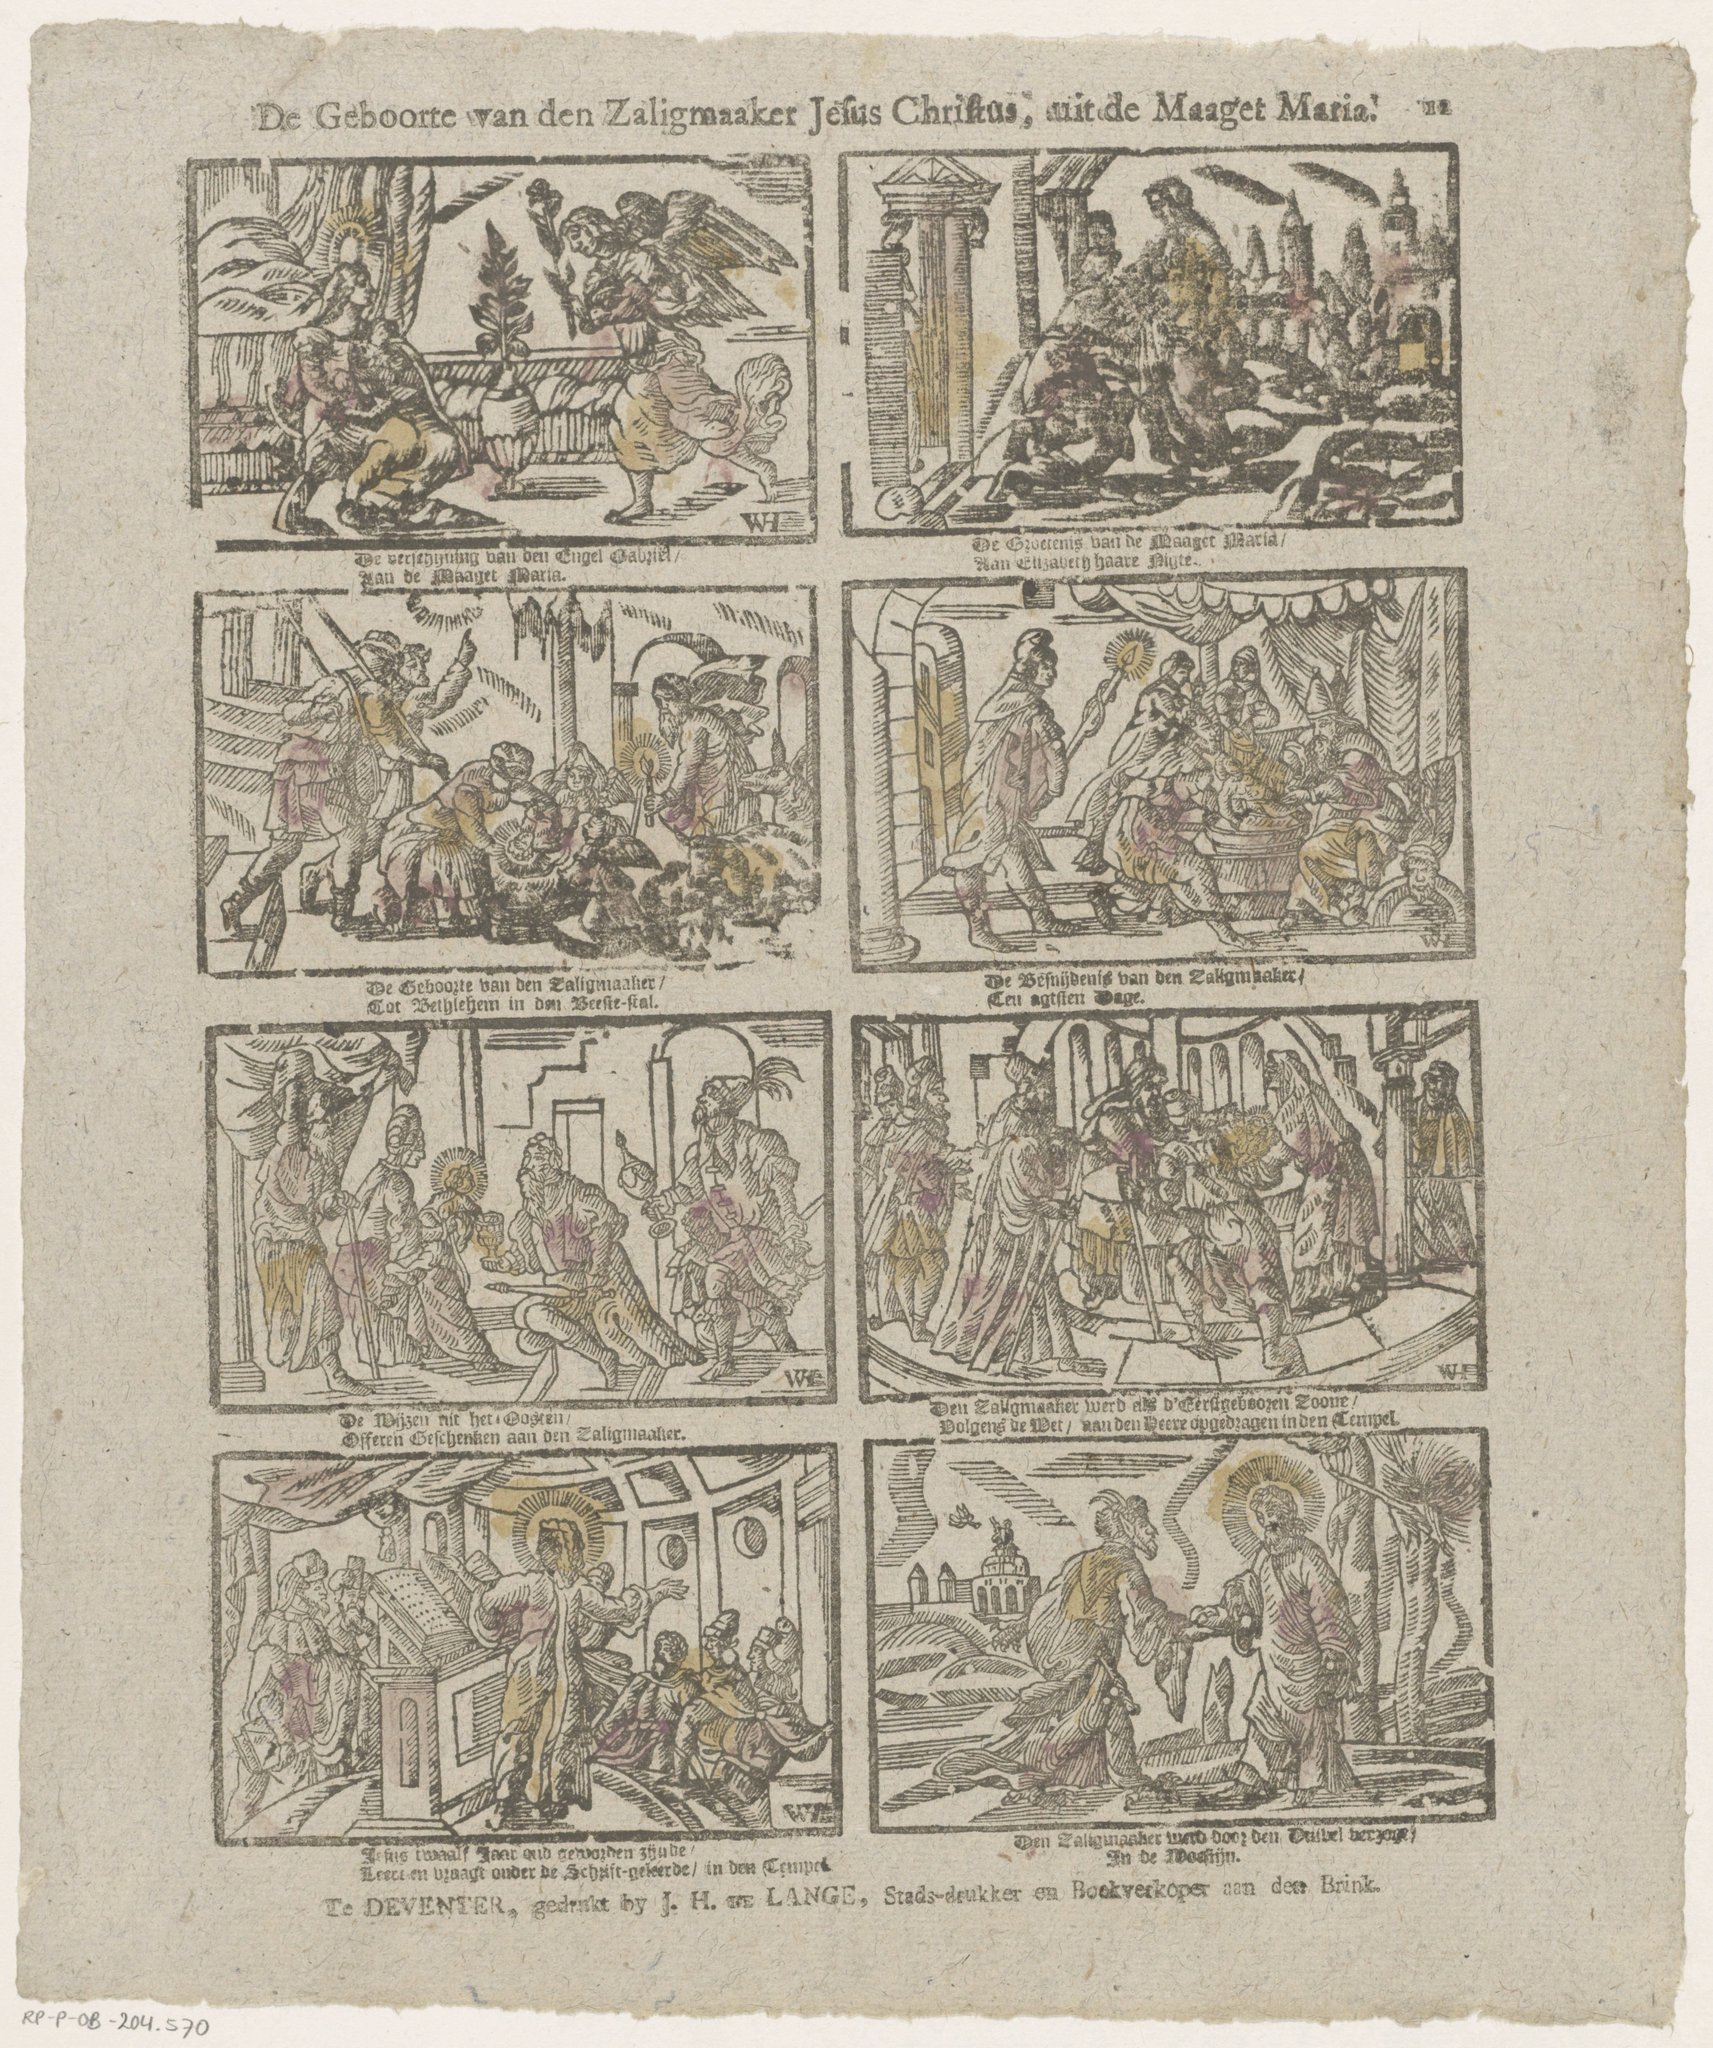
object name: popular print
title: De geboorte van den zaligmaaker Jesus Christus, uit de maaget Maria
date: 1787-1822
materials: paper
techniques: colour, letterpress printing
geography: deventer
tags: adoration of the christ-child by the shepherds; mary and joseph present, new testament, the annunciation: mary sitting, series of scenes from the life of christ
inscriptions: collector's mark: Lugt 2760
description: Blad met 8 voorstellingen uit het leven van Christus, zoals de aanbidding door de herders en en verzoeking in de woestijn. Onder elke afbeelding een tweeregelig vers. Genummerd rechtsboven: 12.